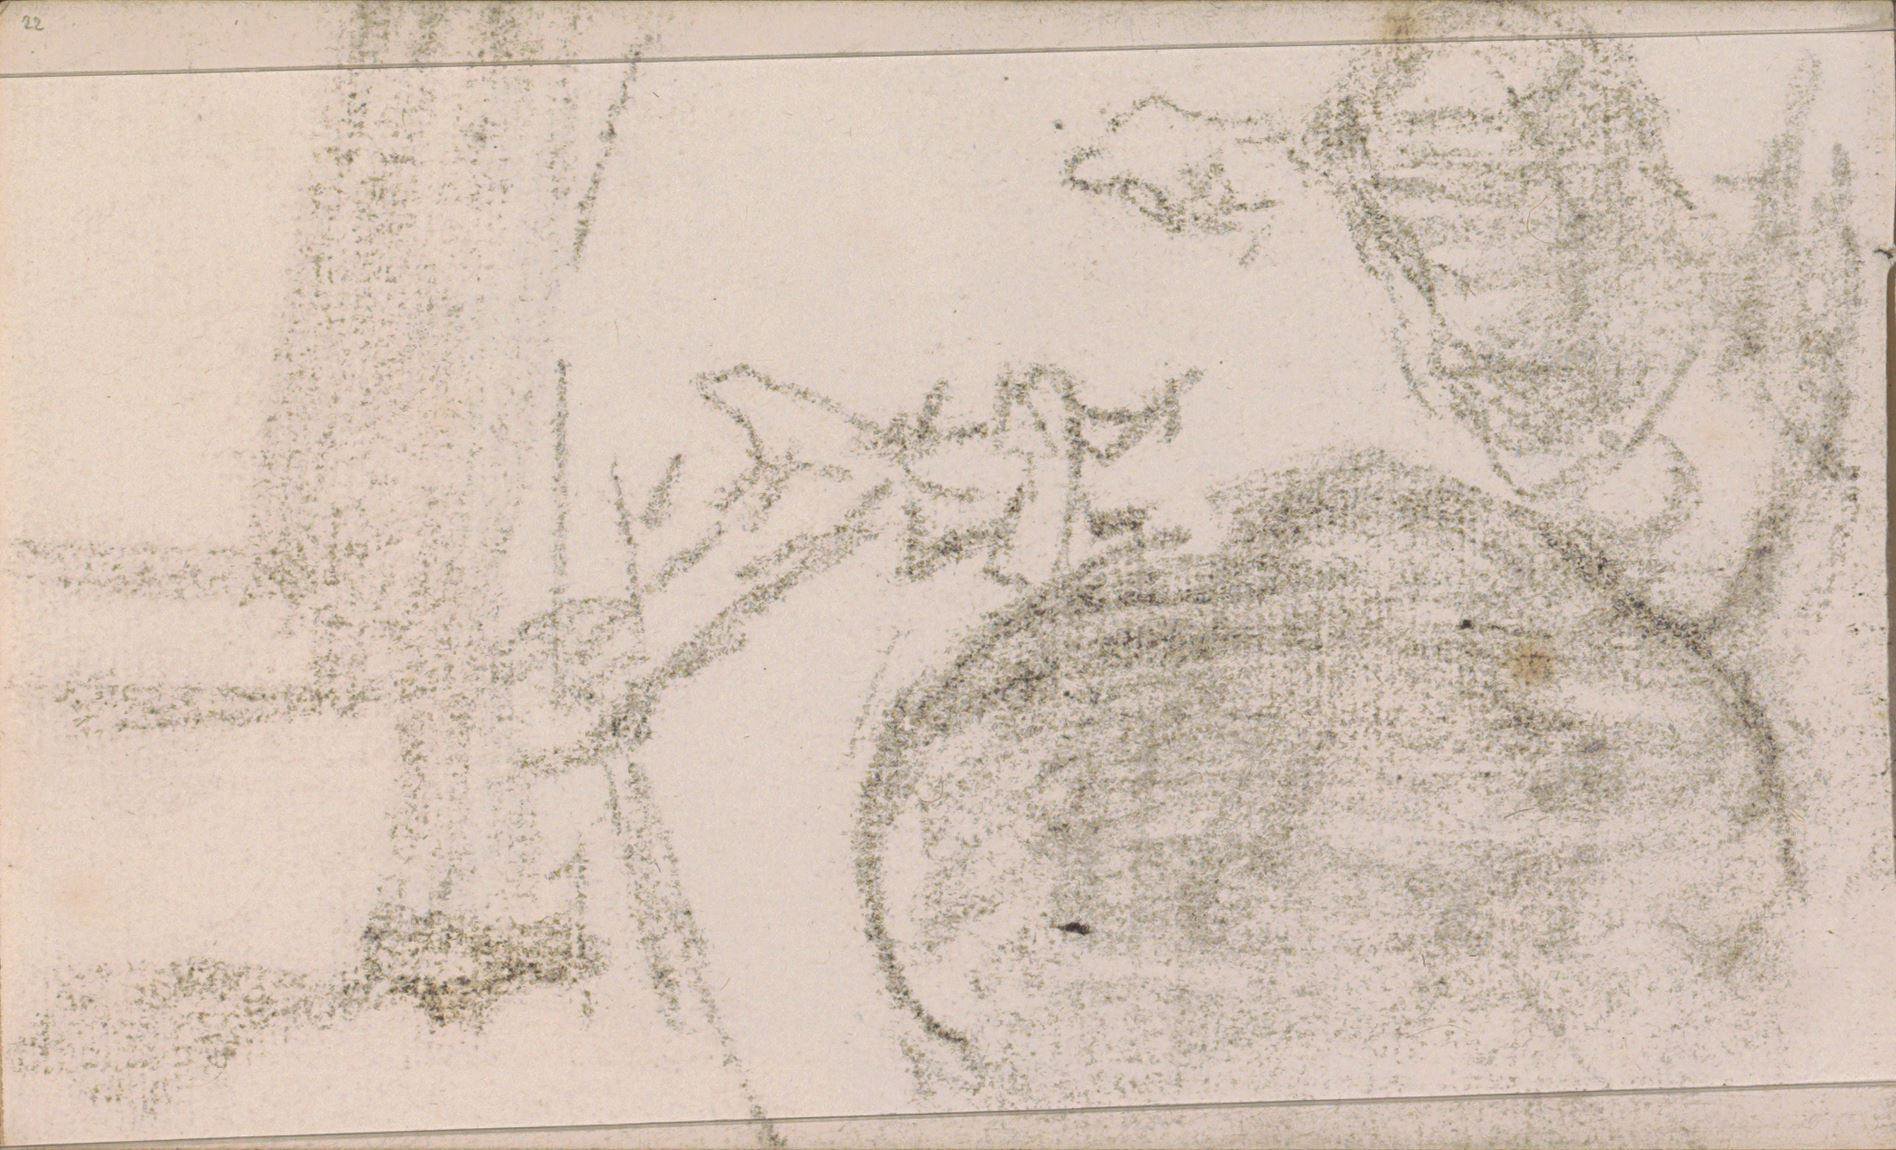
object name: sketchbook leaf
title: Abklatsch van de krijttekening op pagina 23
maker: isaac israels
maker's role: draughtsman, painter, print maker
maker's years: 1865-1934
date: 1875-1934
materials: paper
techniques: printmaking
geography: the hague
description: Pagina 22 uit schetsboek XLVIII met 62 pagina's.